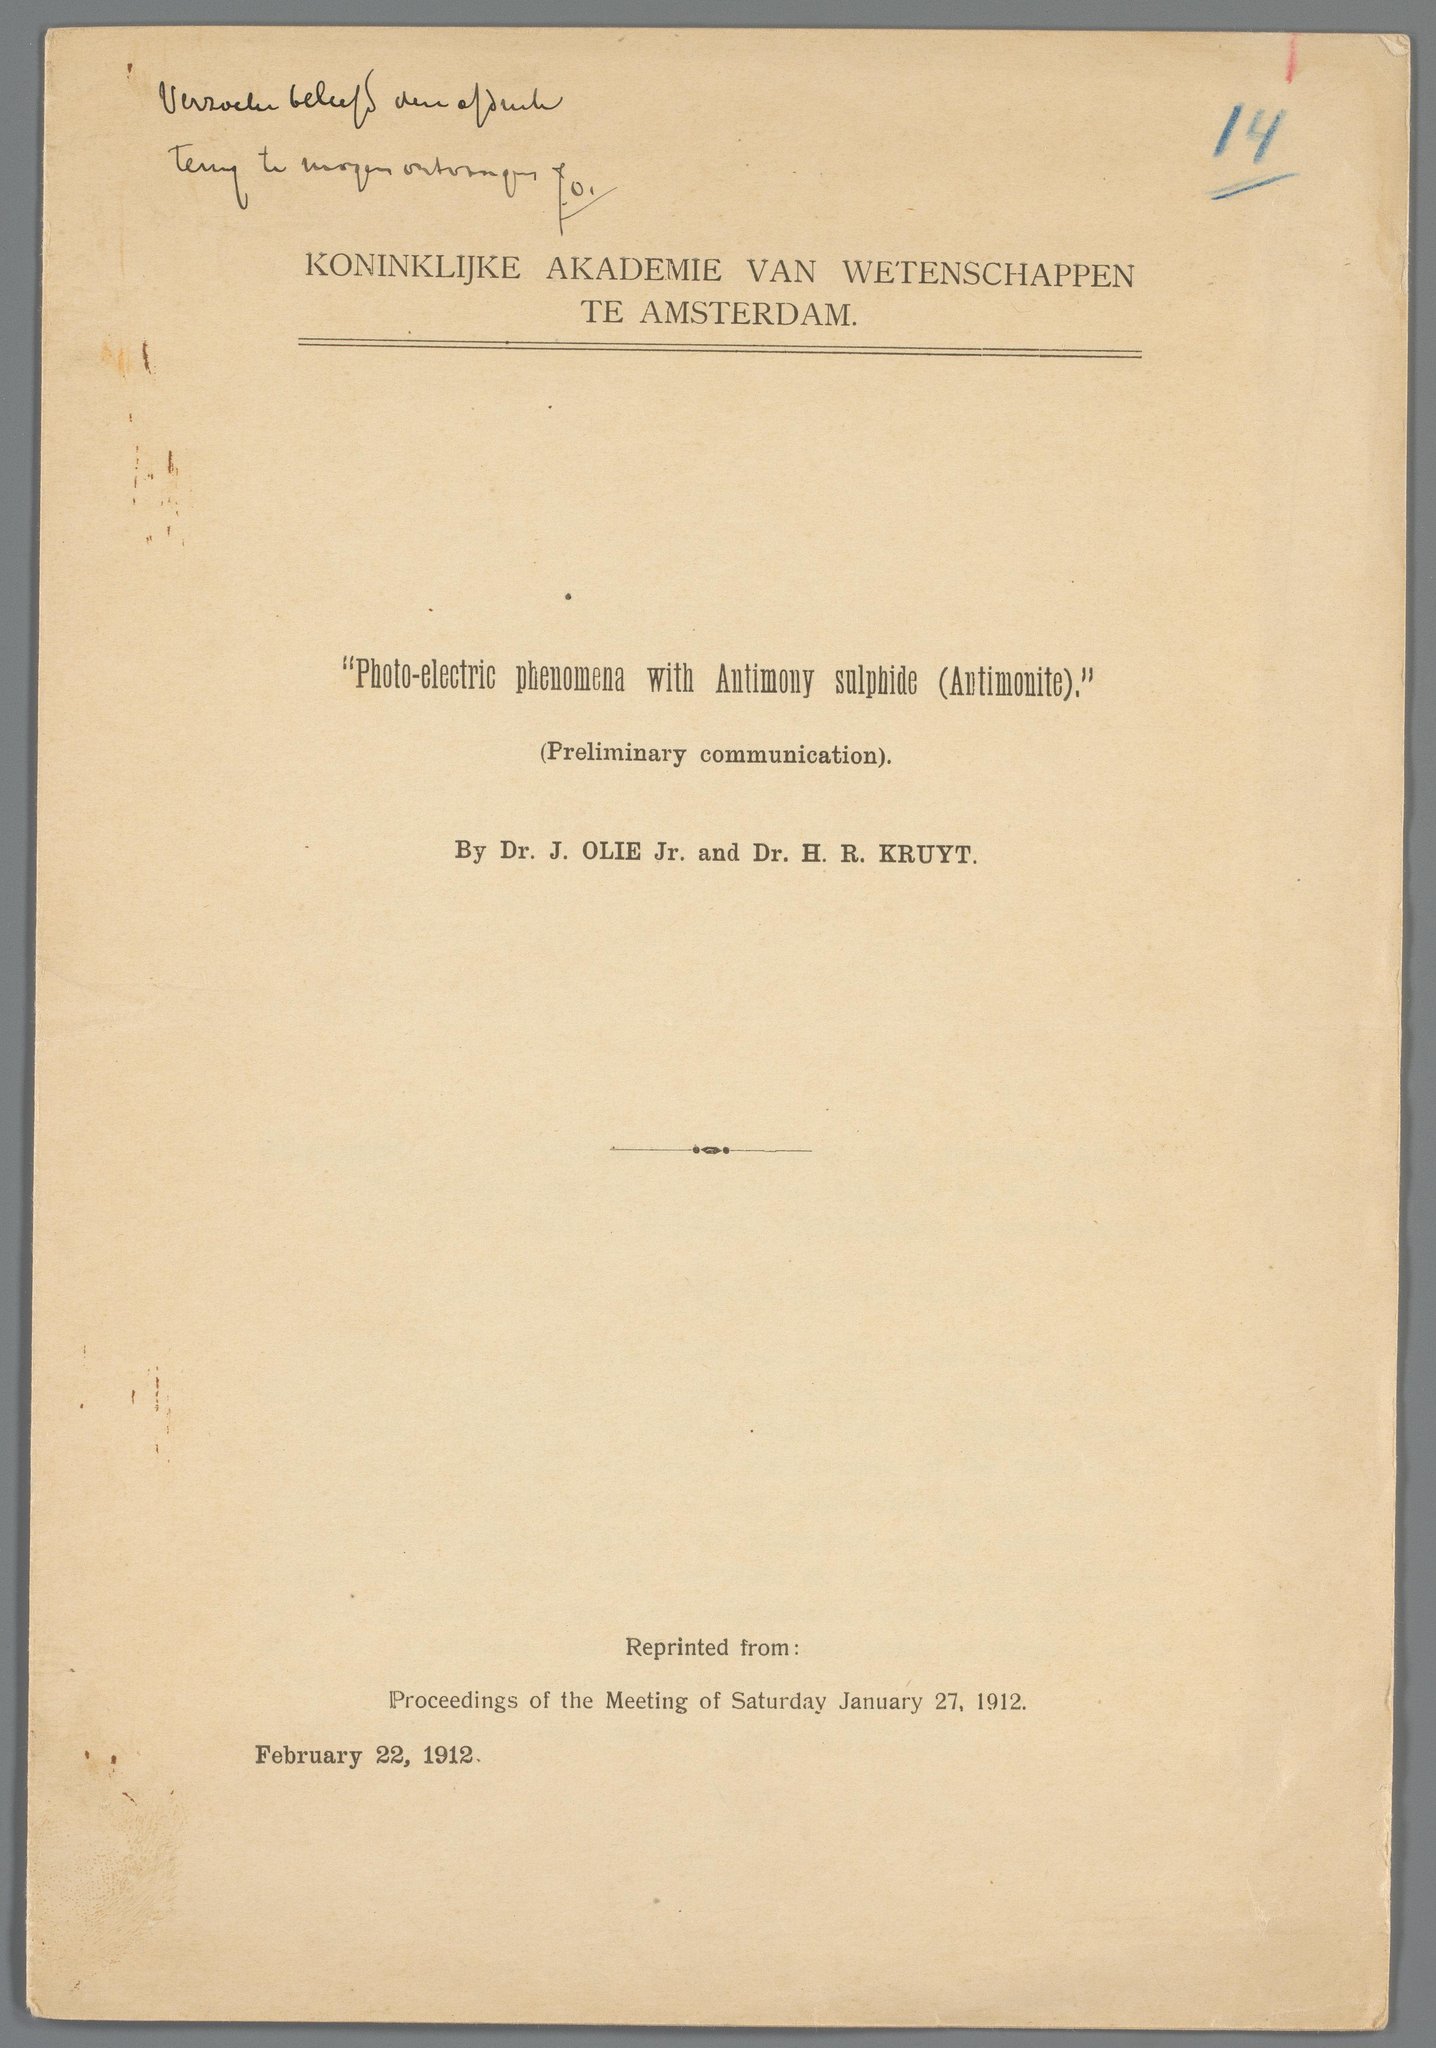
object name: offprint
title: Onderzoeksverslag over fotoelectrische verschijnselen met antimoonsulfide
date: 1912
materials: paper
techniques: letterpress printing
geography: amsterdam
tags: printed matter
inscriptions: inscription: ‘Verzoeken beleefd den afdruk/ Terug te mogen ontvangen/ Jo’, number: ‘14’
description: Overdruk uit het verslag van de vergadering van de Koninklijke Akademie van Wetenschappen Amsterdam op zaterdag 27 januari 1912.